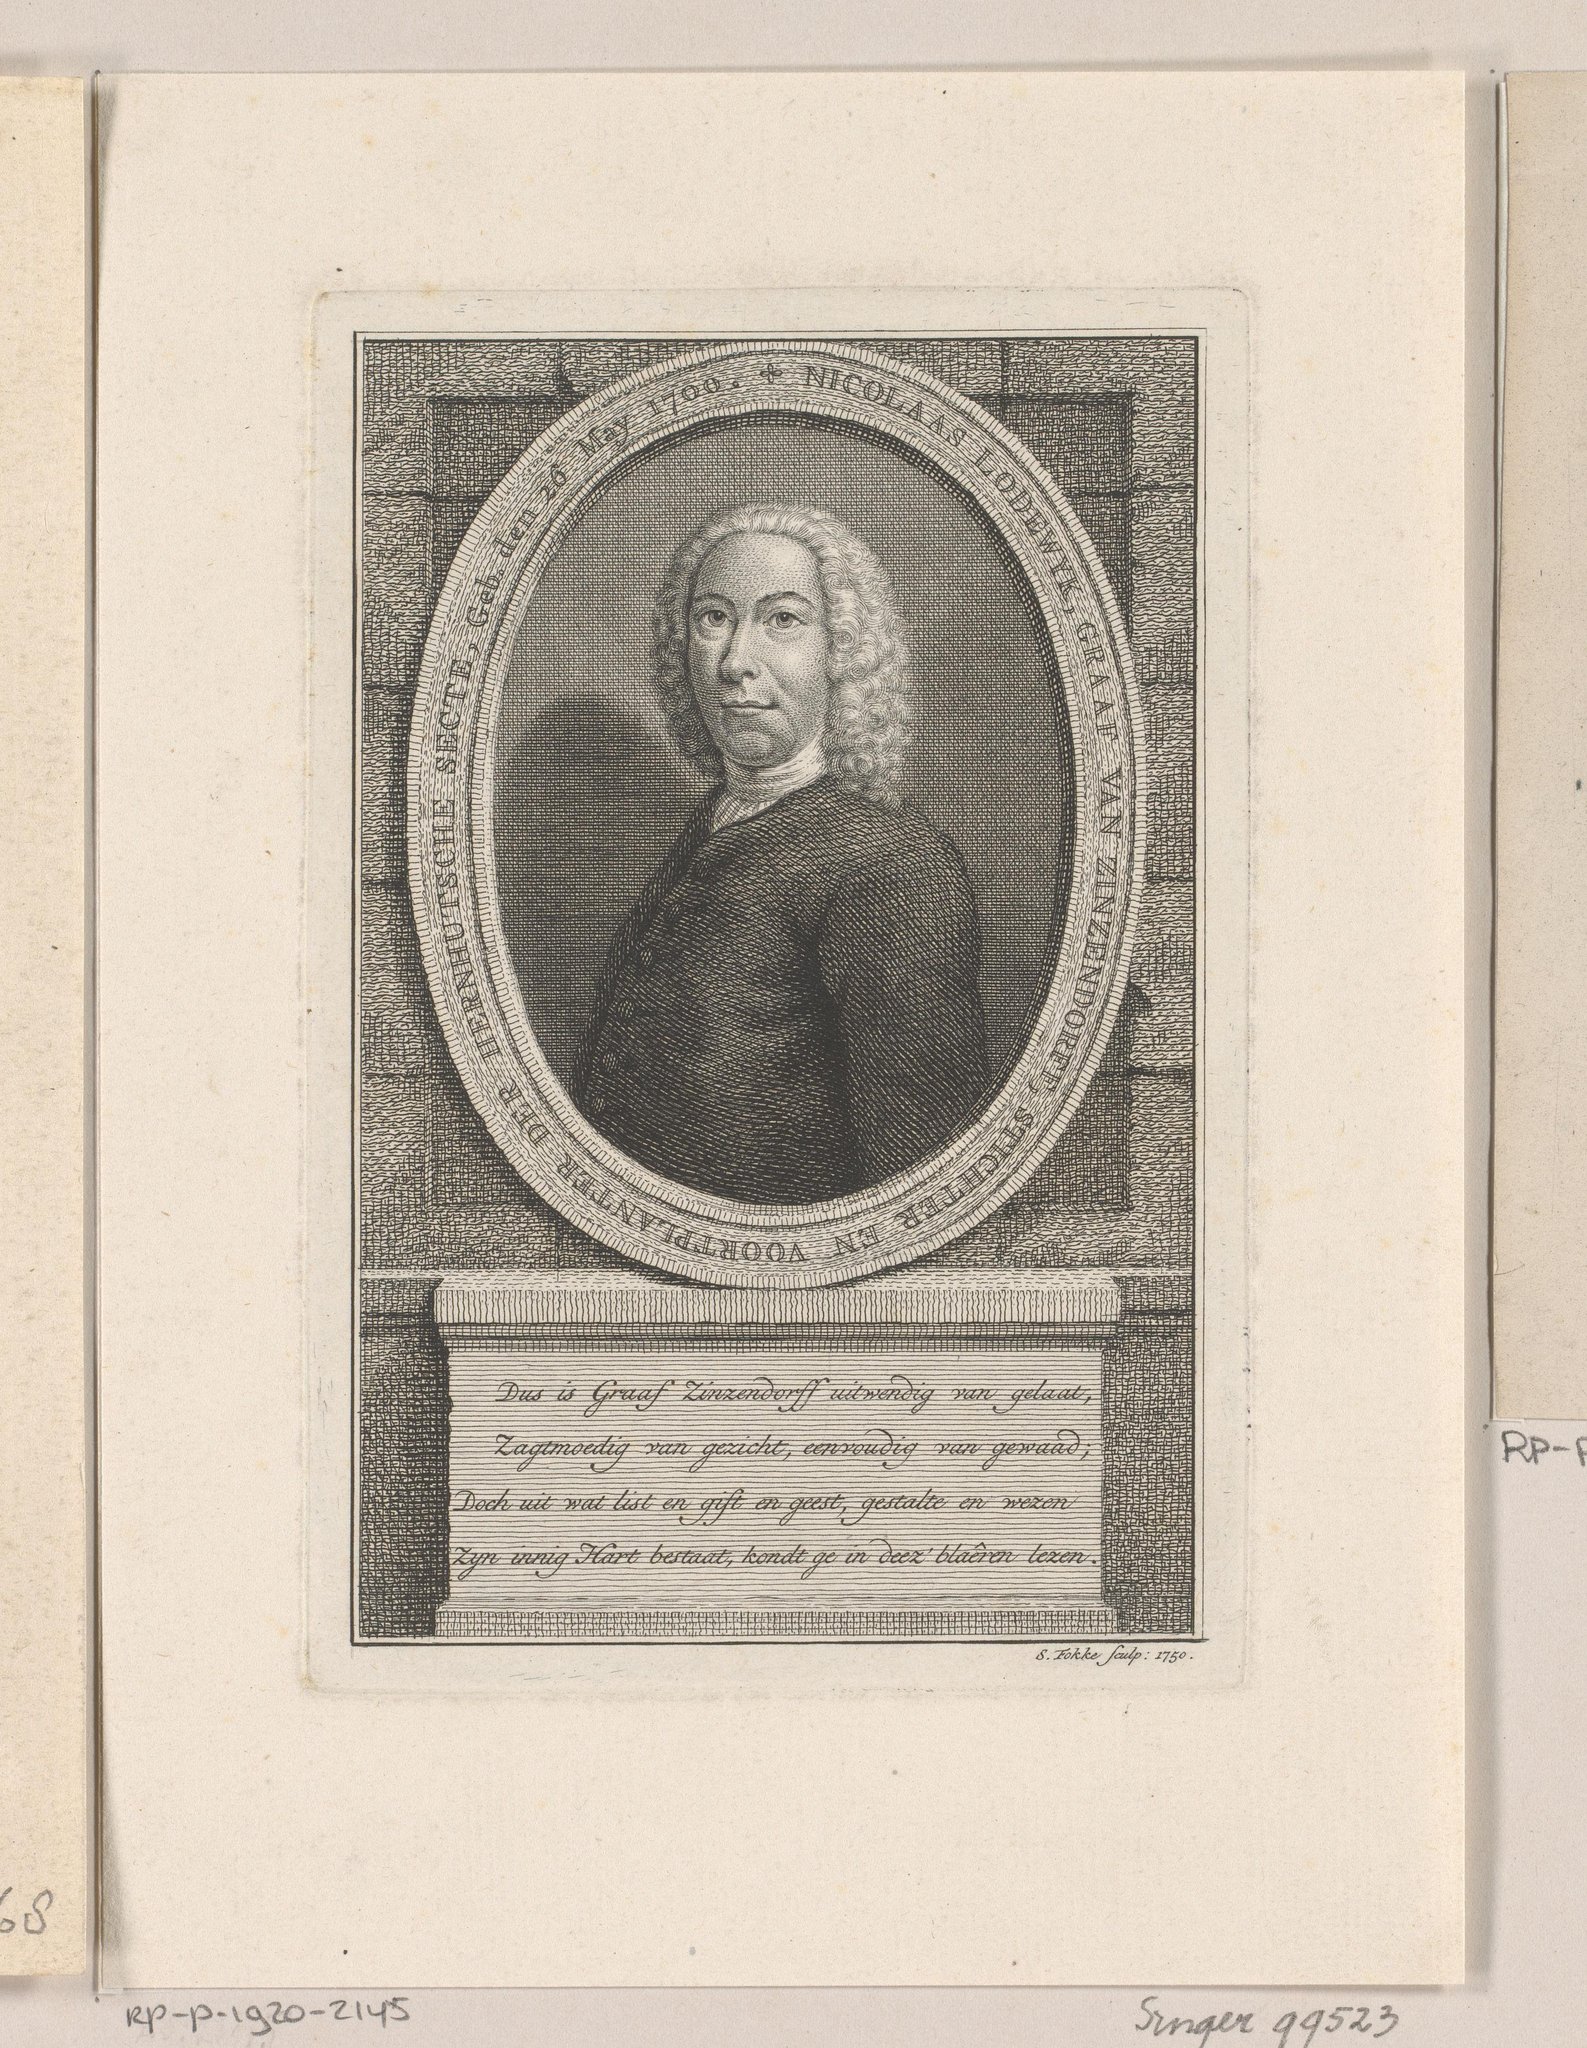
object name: print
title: Portret van Nikolaus Ludwig Graf von Zinzendorf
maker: simon fokke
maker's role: draughtsman, print maker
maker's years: 1712-1784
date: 1750-1751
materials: paper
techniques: etching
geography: amsterdam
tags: earl, historical persons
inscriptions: collector's mark: Lugt 2228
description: Prent waarschijnlijk uit: Volck, Alexander. De verborgenheid der ongerechtigheid van de secte der Hernhutters ontdekt ... in 6 zamenspraken vervat. Amsterdam: Gerrit de Groot, 1751.